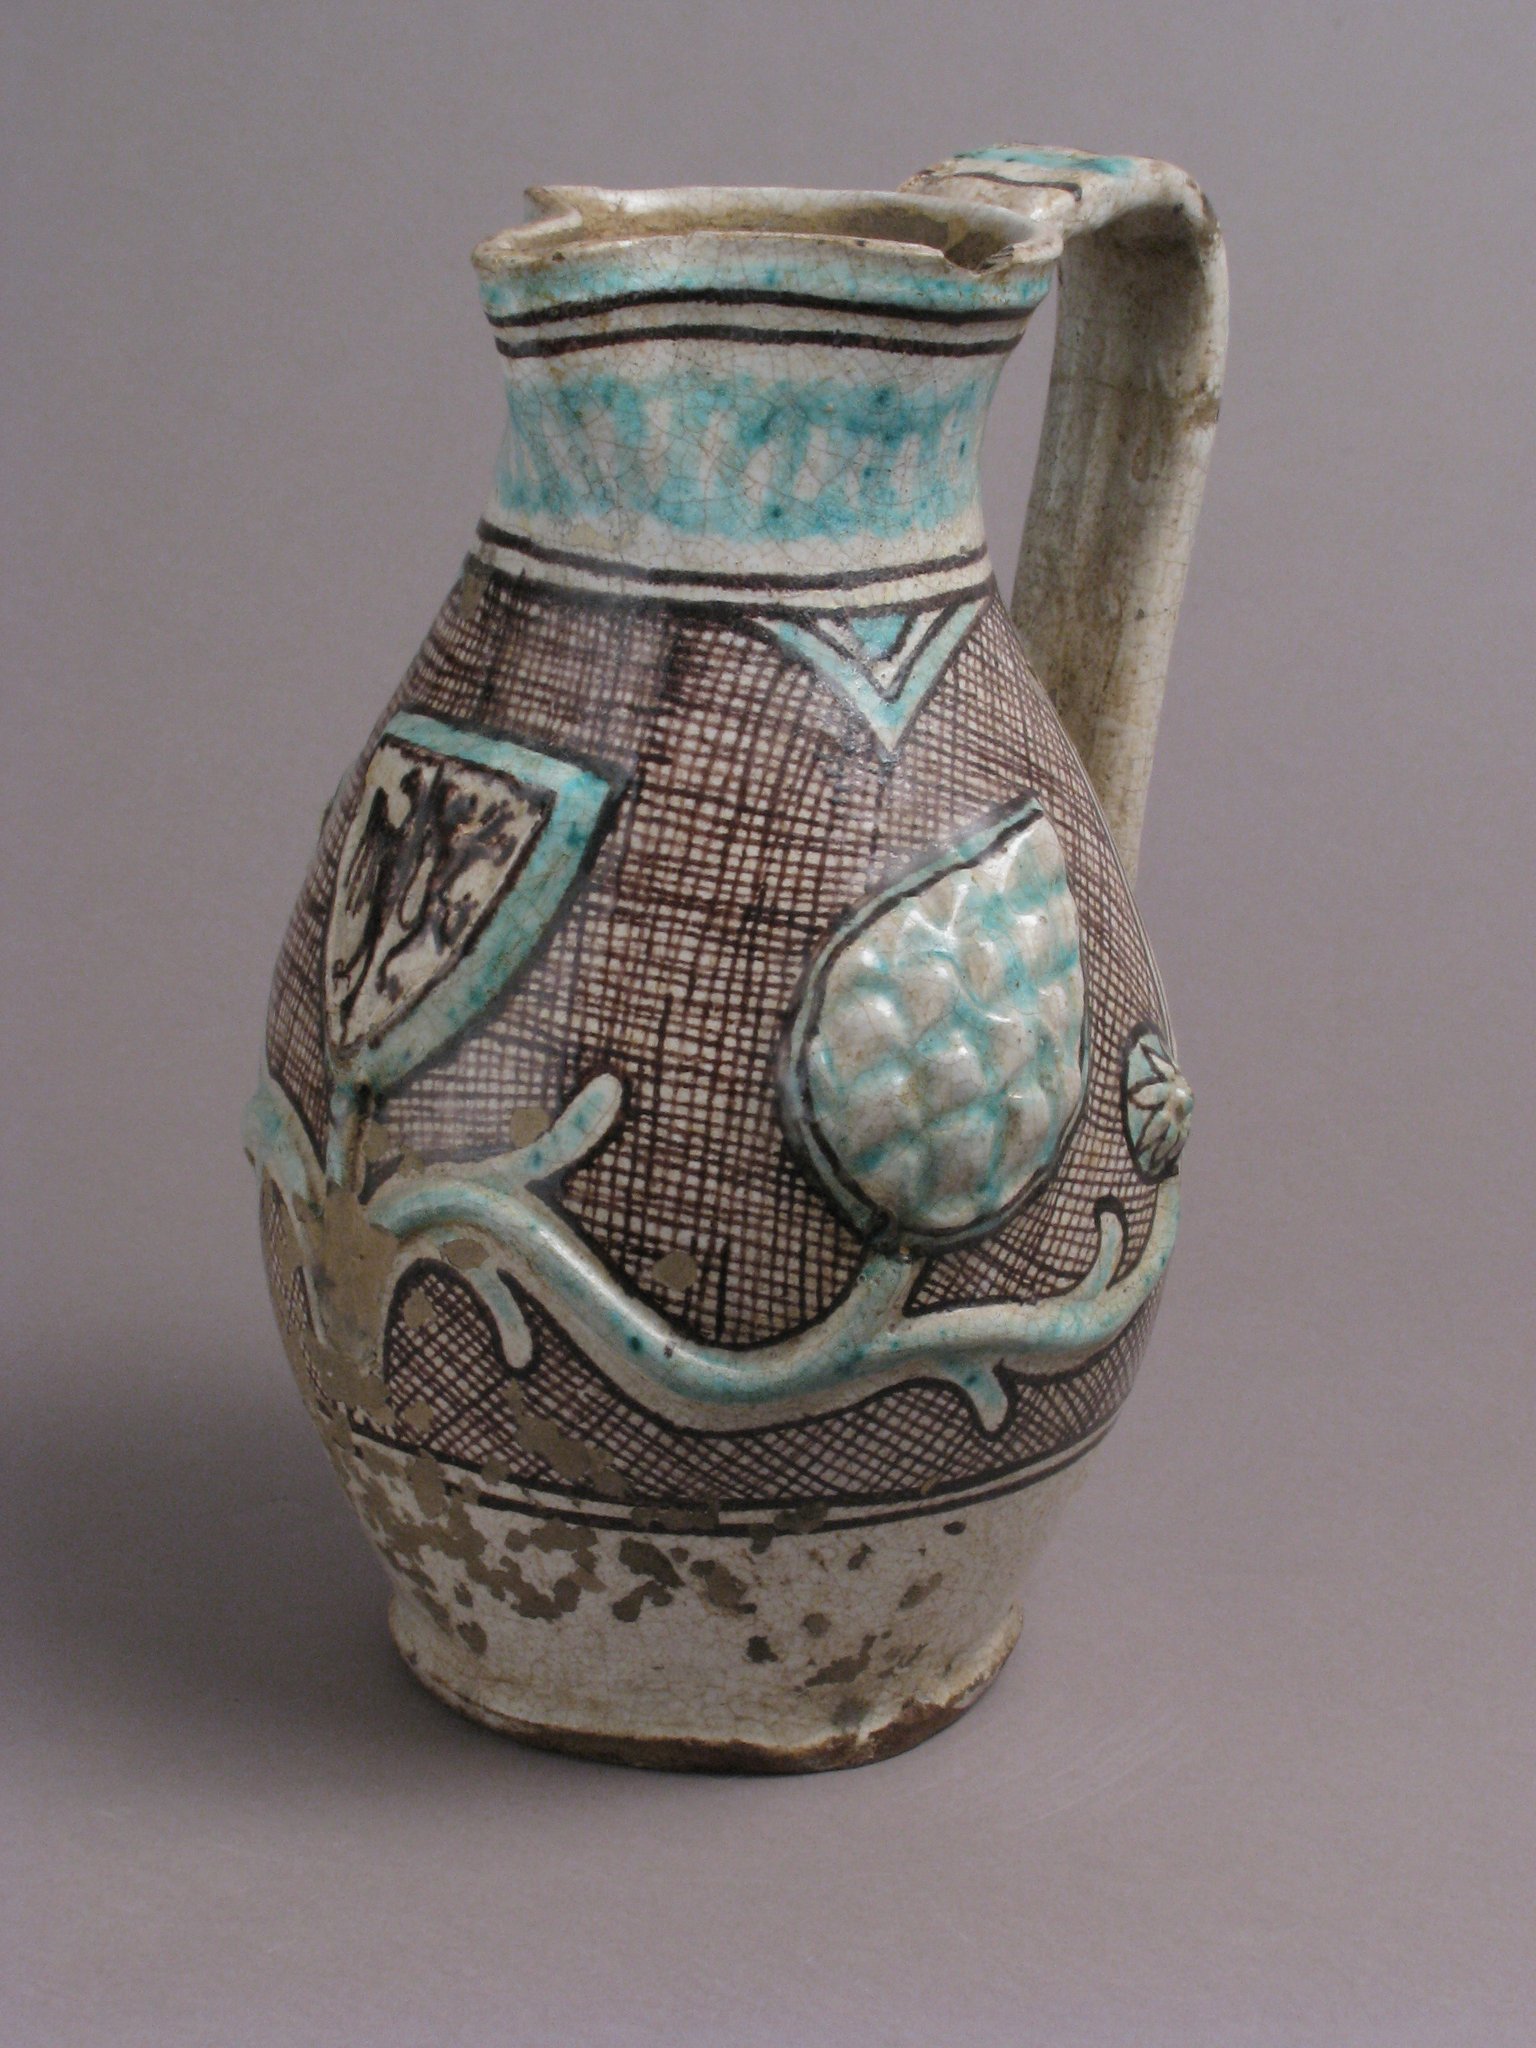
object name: jug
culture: italian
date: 1401-1500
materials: earthenware, glaze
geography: italy